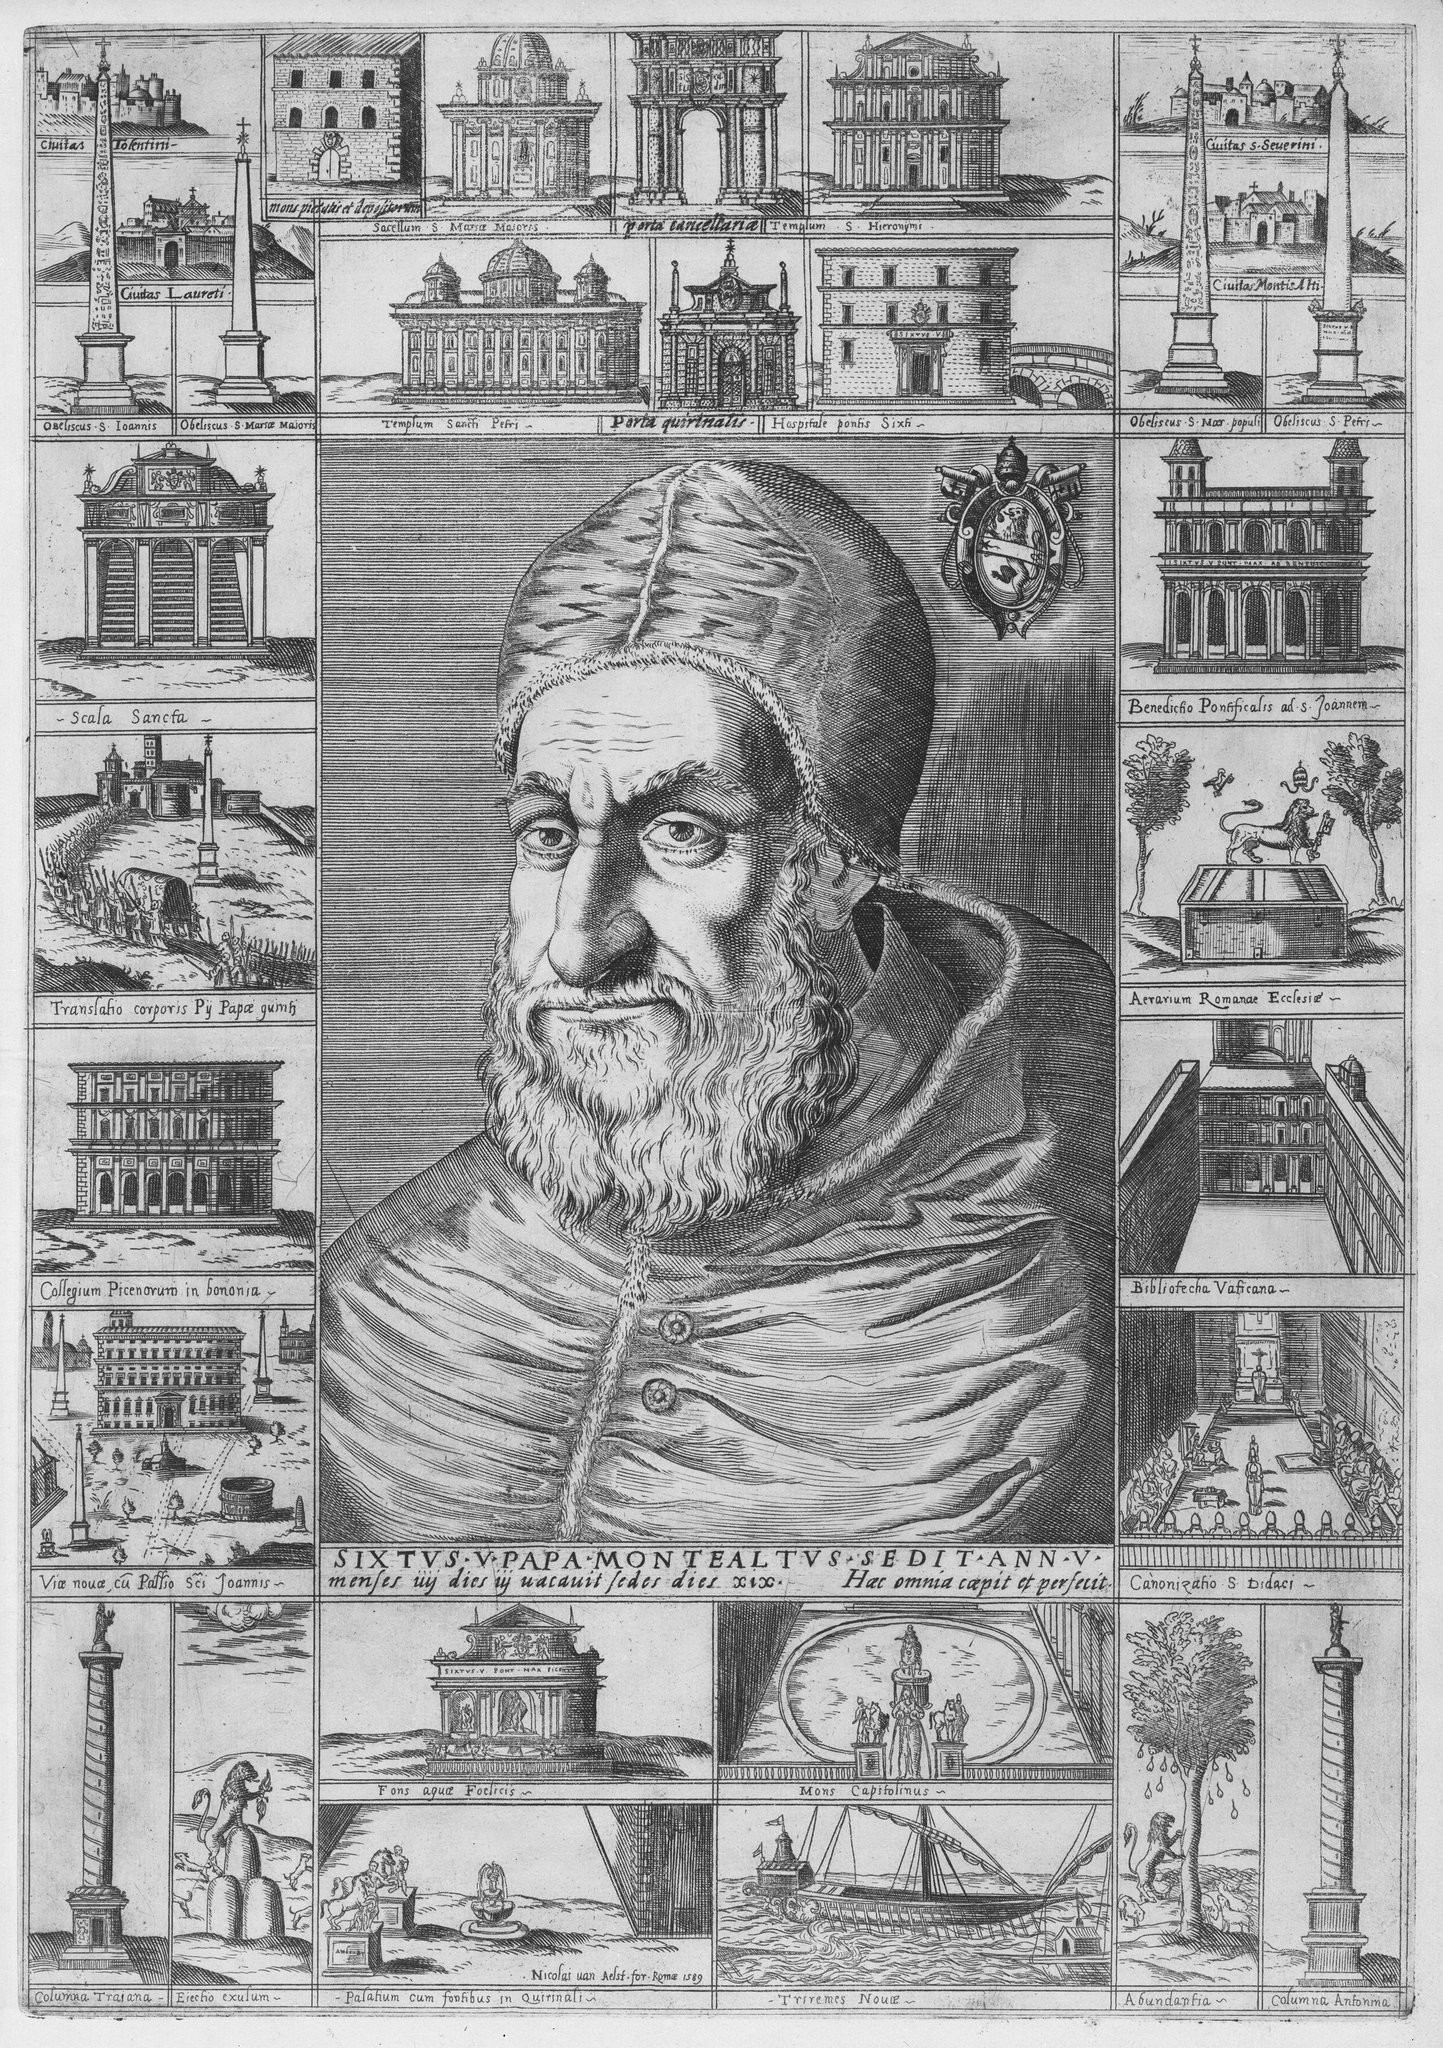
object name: print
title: Portrait of Sixtus V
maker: nicolaus van aelst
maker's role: publisher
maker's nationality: italian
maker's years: 1526-1613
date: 1589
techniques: engraving, etching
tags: buildings,obelisks,men,portraits,popes